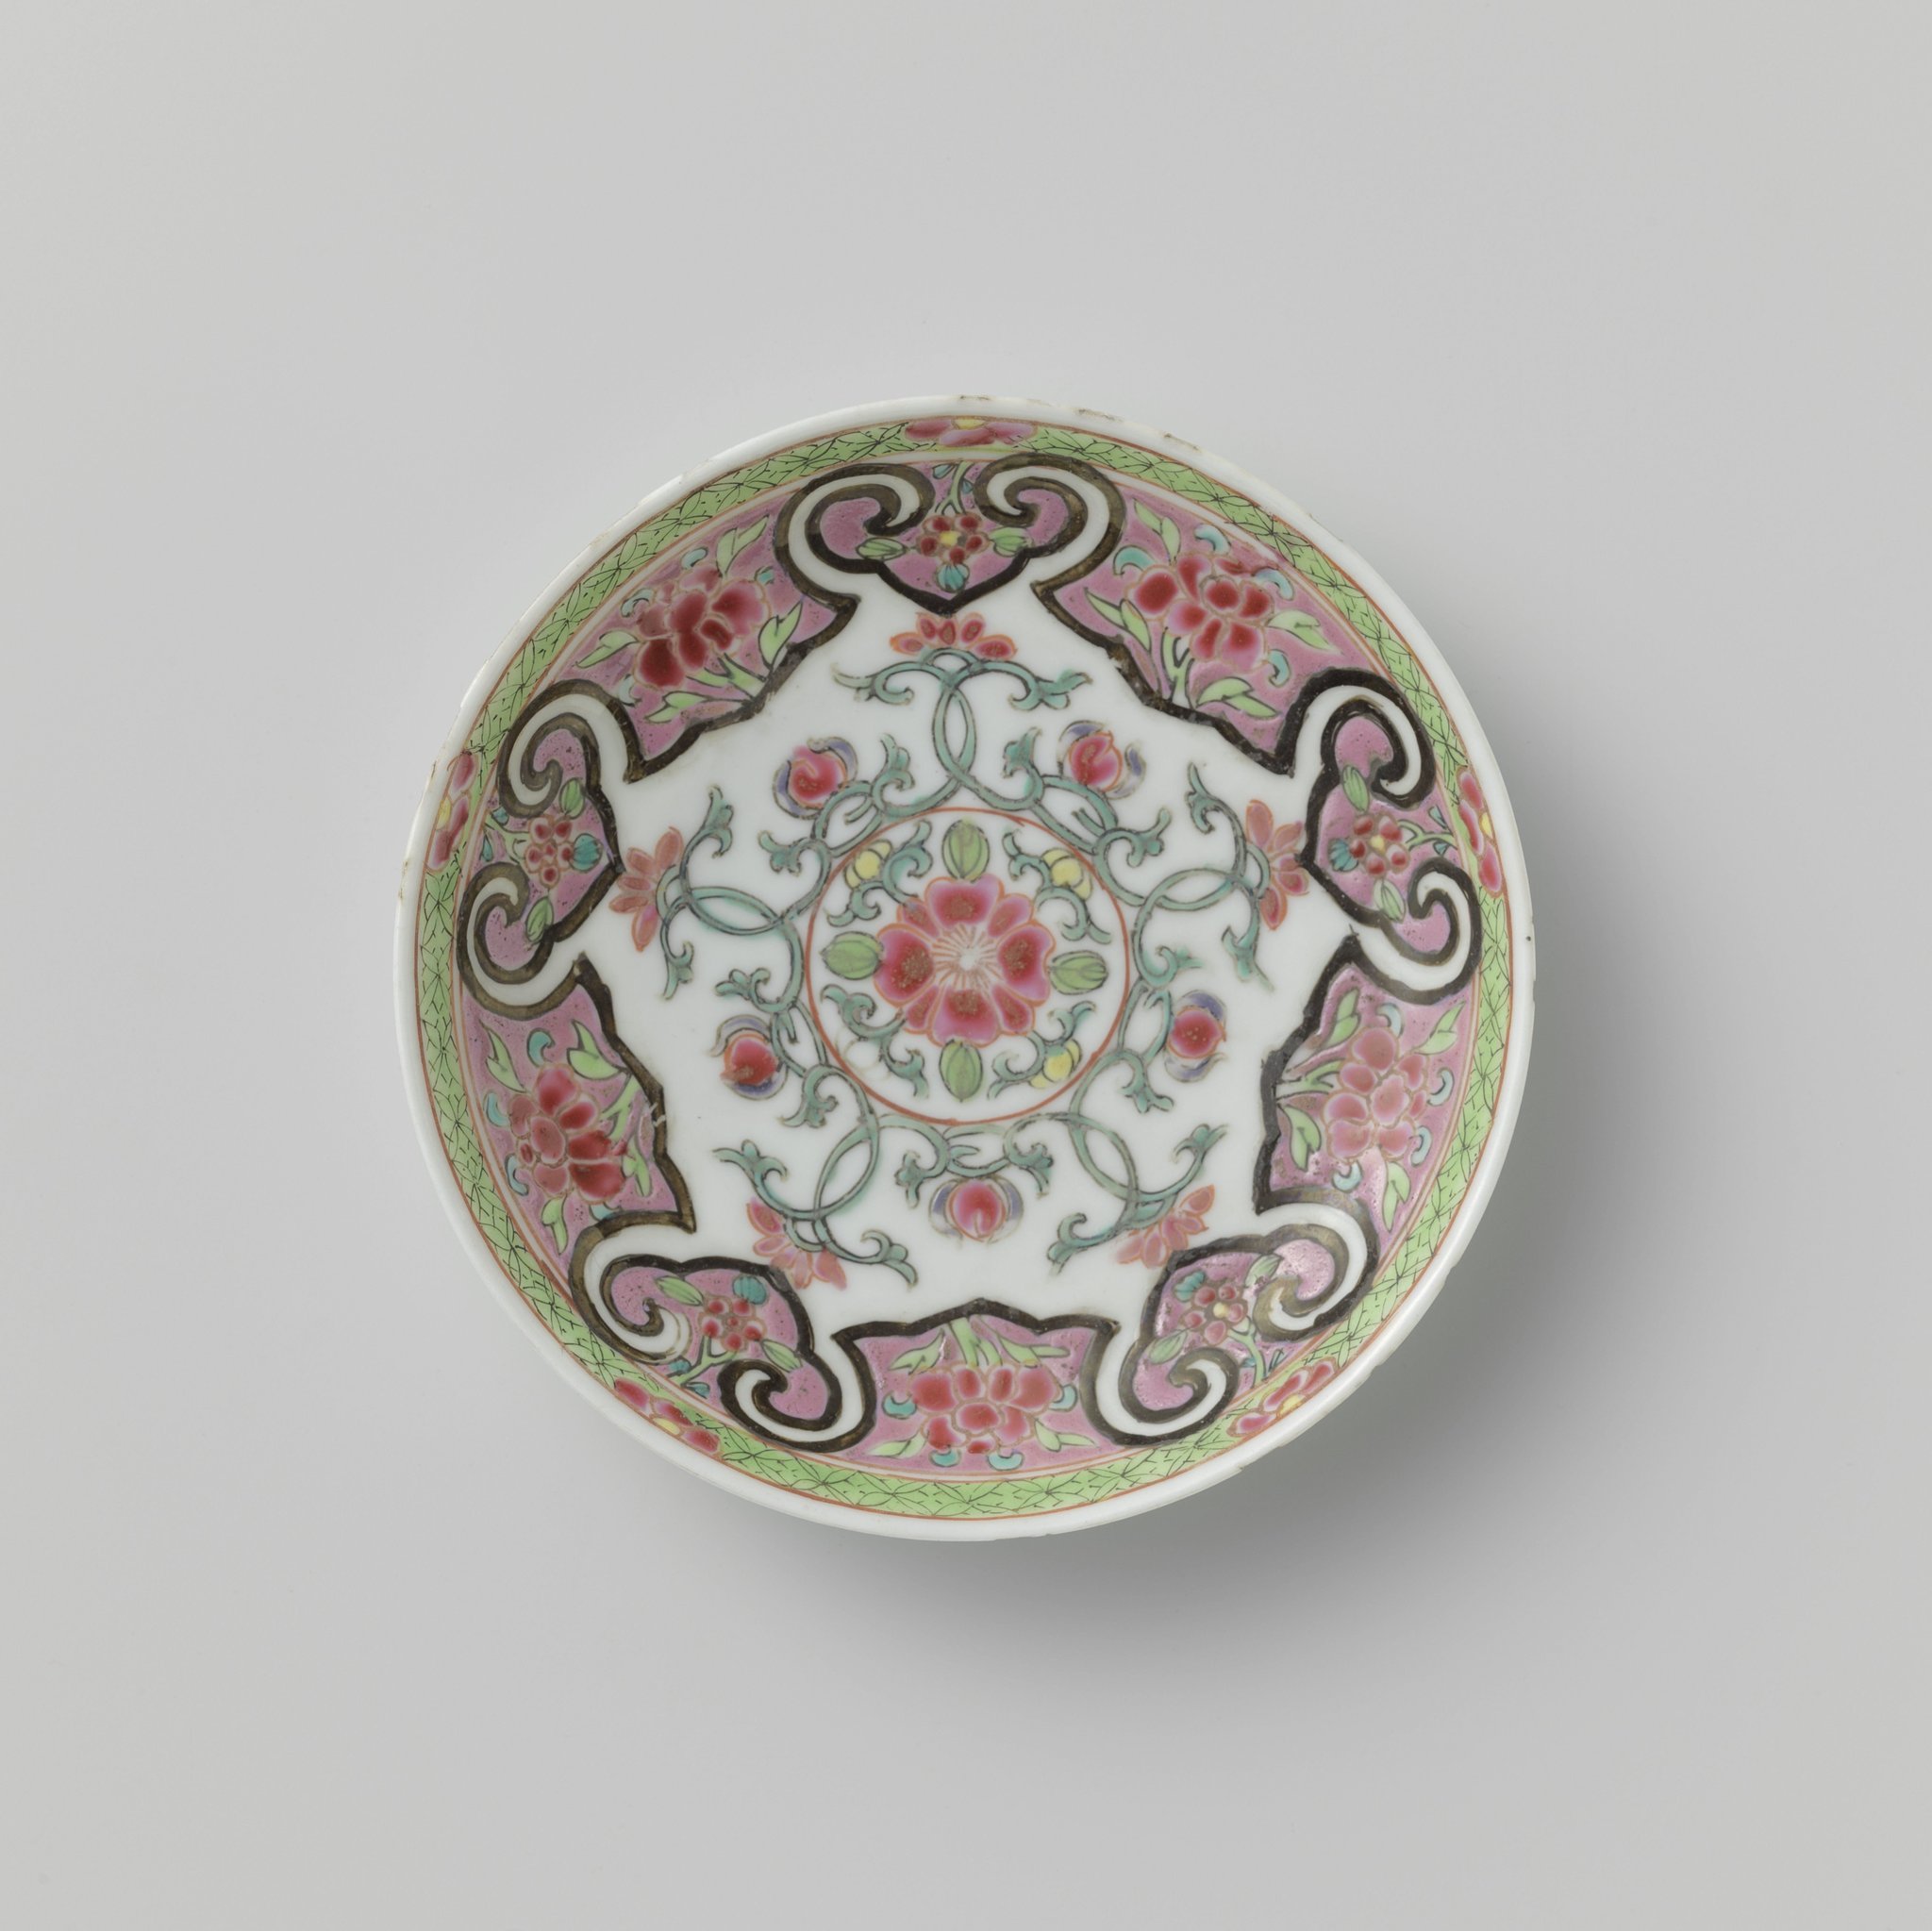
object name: platter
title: Saucer with floral scrolls in a heavily outlined, shaped panel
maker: Anonymous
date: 1740-1760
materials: glaze, paint, porcelain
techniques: firing, turning, vitrification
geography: china